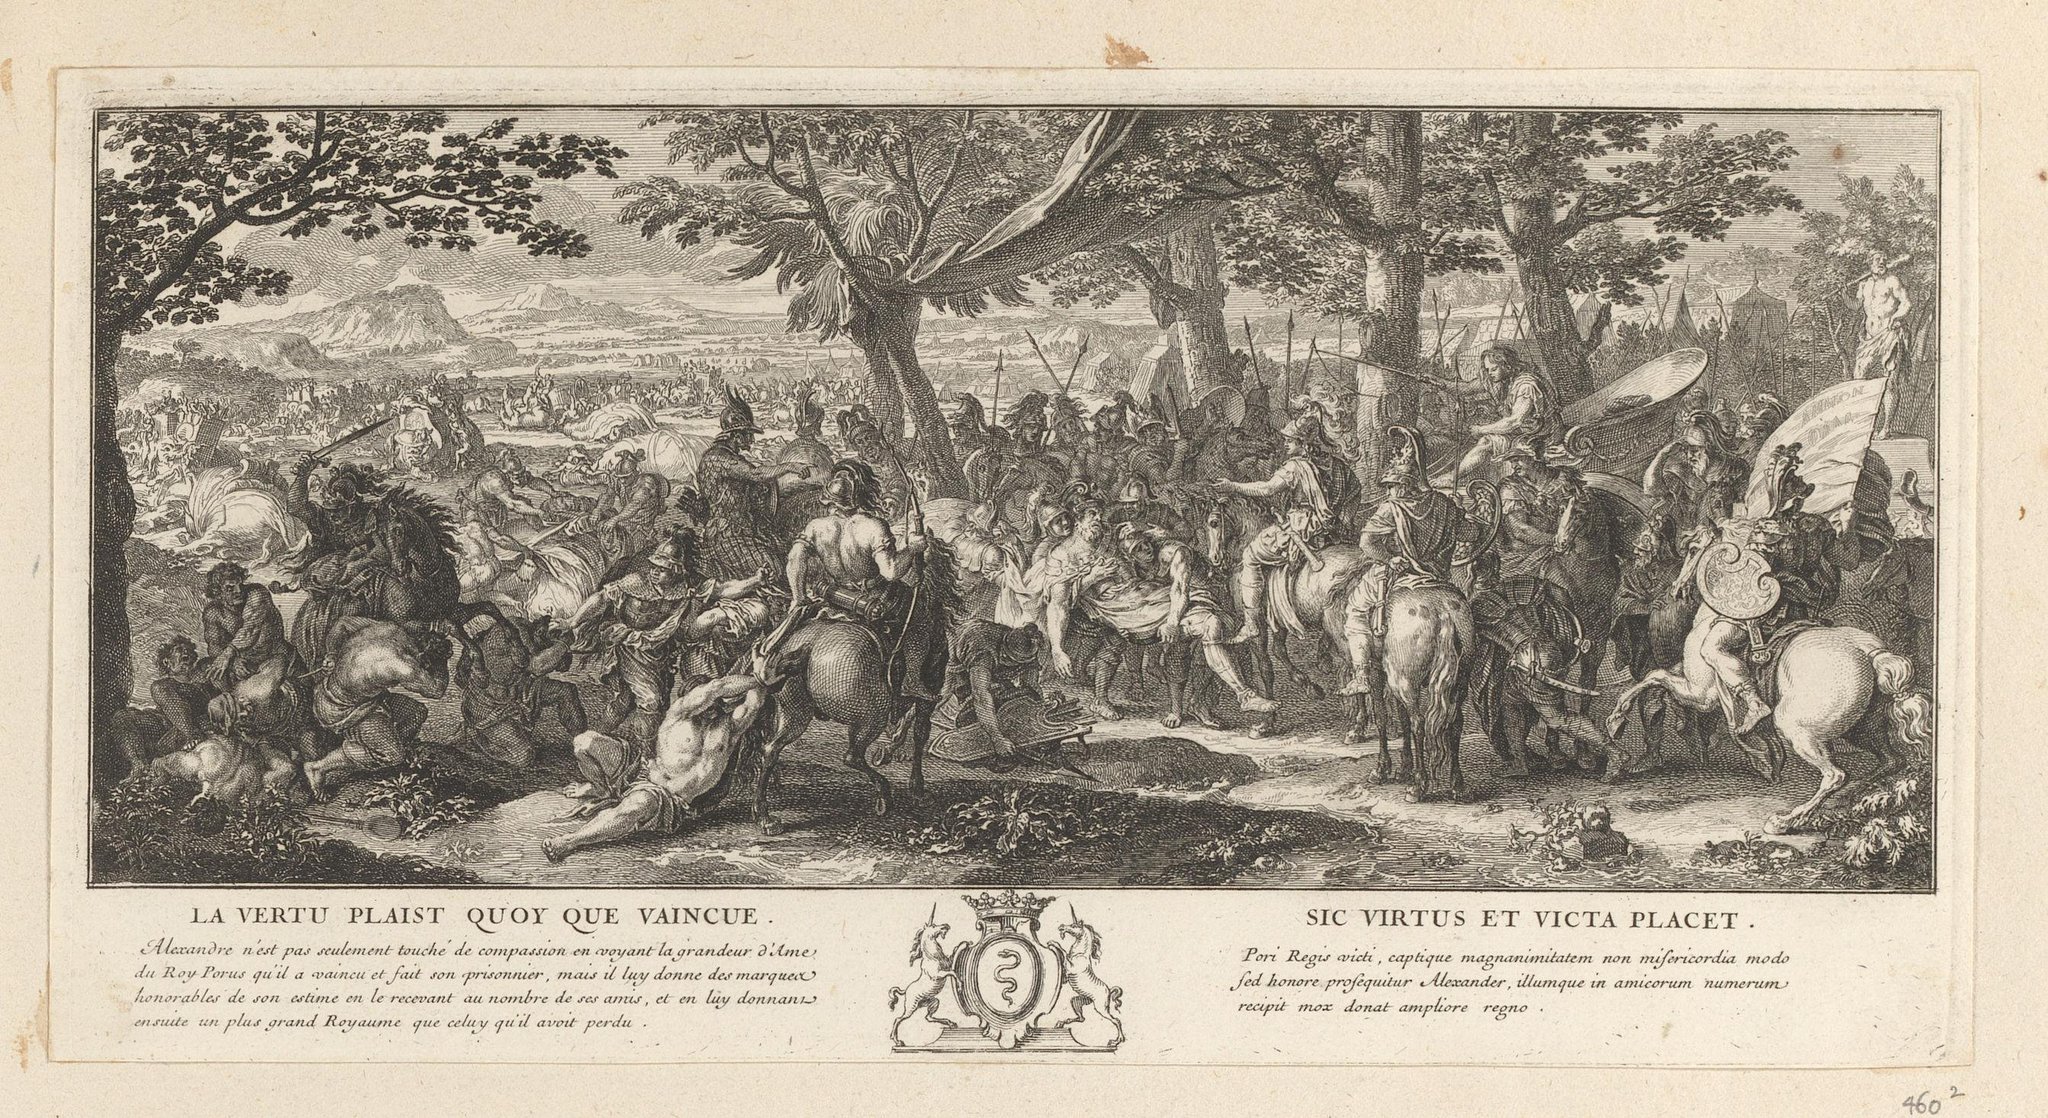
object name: print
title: Les batailles d'Alexandre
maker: sébastien leclerc (i)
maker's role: print maker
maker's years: 1637-1714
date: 1696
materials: paper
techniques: engraving, etching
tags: the defeated king porus, covered with wounds, comes before alexander, who restores his dominions, i.e. the clemency of alexander, historical persons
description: Na de slag bij de Hydaspes wordt de gewonde koning Porus voor Alexander de Grote gebracht. Onder de voorstelling het wapenschild van Edouard Colbert de Villacerf. Prent maakt deel uit van een album.